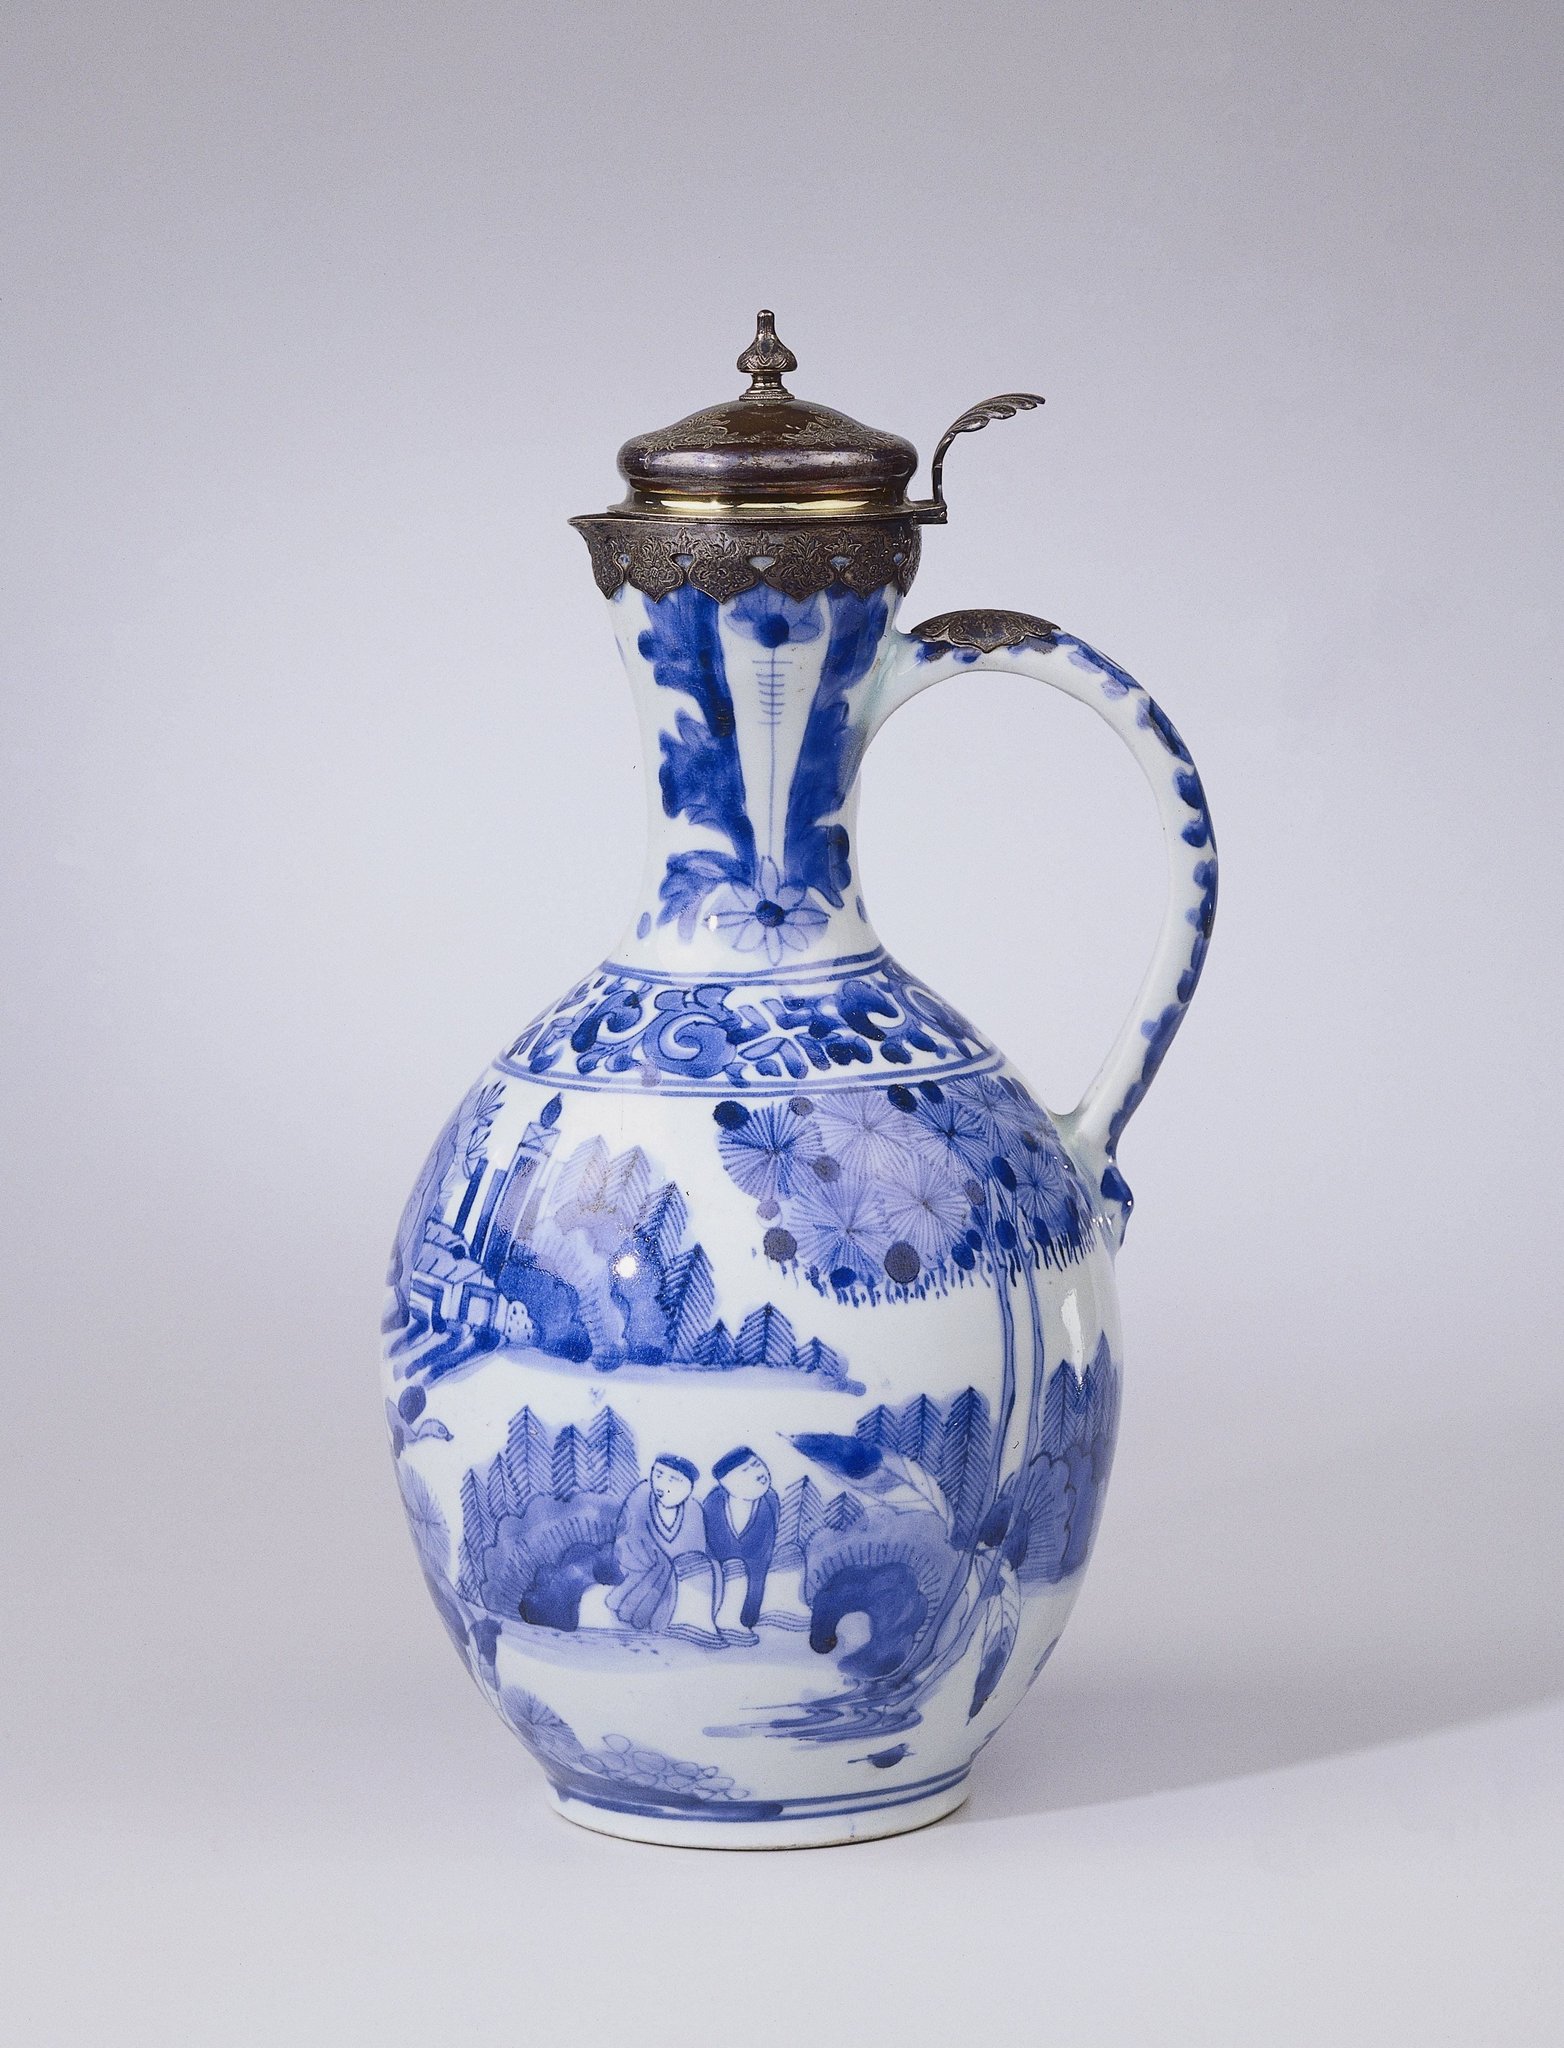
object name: flagon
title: Ewer with figures in a landscape, floral scrolls, tulip motif and silver mount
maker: Anonymous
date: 1650-1699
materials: cobalt, glaze, paint, porcelain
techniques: firing, turning, vitrification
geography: arita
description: Schenkkan van porselein met bolvormig lichaam, c-vormig oor en kleine, driehoekig tuit in de rand. Beschilderd in onderglazuur blauw. Op de buik een doorlopende voorstelling met mensen in een landschap met rots, bomen, planten, een vliegende vogel en huizen. Een persoon heeft een vlag in de hand. Op de schouder een band met ranken. De schouder met tweemaal een tulpmotief. Op het oor ranken. Om de rand een later toegevoegd zilveren montuur met deksel, jaarletter Z (1859). Arita, blauw-wit.